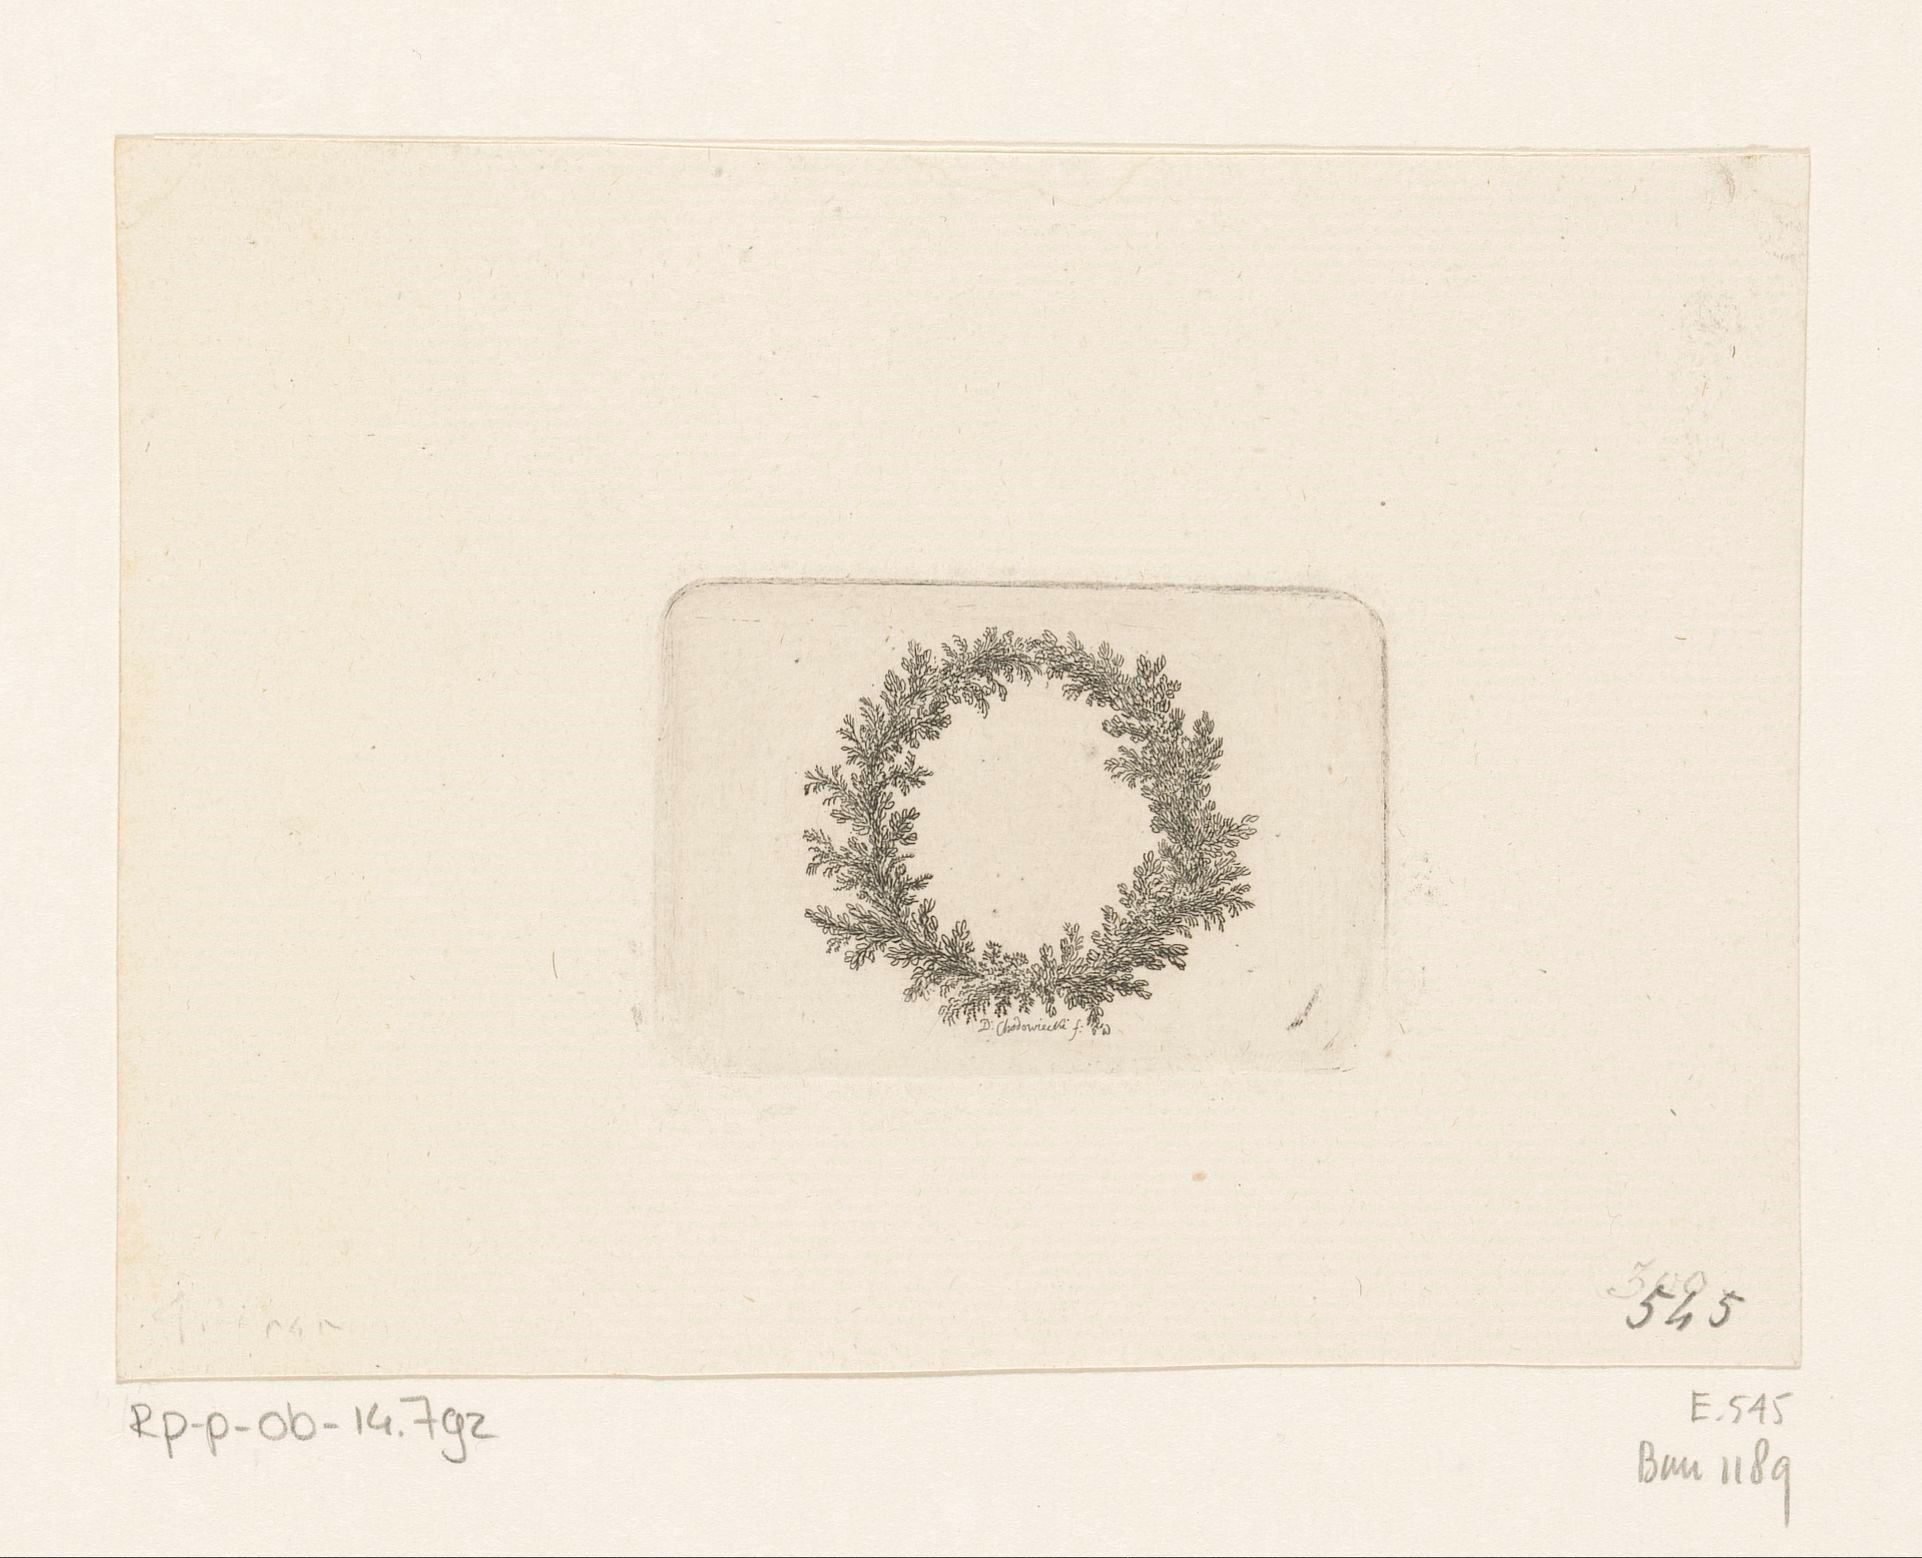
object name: print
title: Krans van laurier en mirte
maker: daniel nikolaus chodowiecki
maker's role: draughtsman, print maker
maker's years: 1726-1801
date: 1785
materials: paper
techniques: etching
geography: berlin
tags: garland, wreath, trees: laurel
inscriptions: collector's mark: Lugt 2228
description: Prent gebruikt voor: Karschin, Anna Luise. Der Nachruhm am Begräbnisstage meiner seligen Freundin ihrem Chodowiecky. Berlijn: G. J. Decker, 1785. Uitgegeven naar aanleiding van het overlijden van de vrouw van Daniel Nikolaus Chodowiecki.